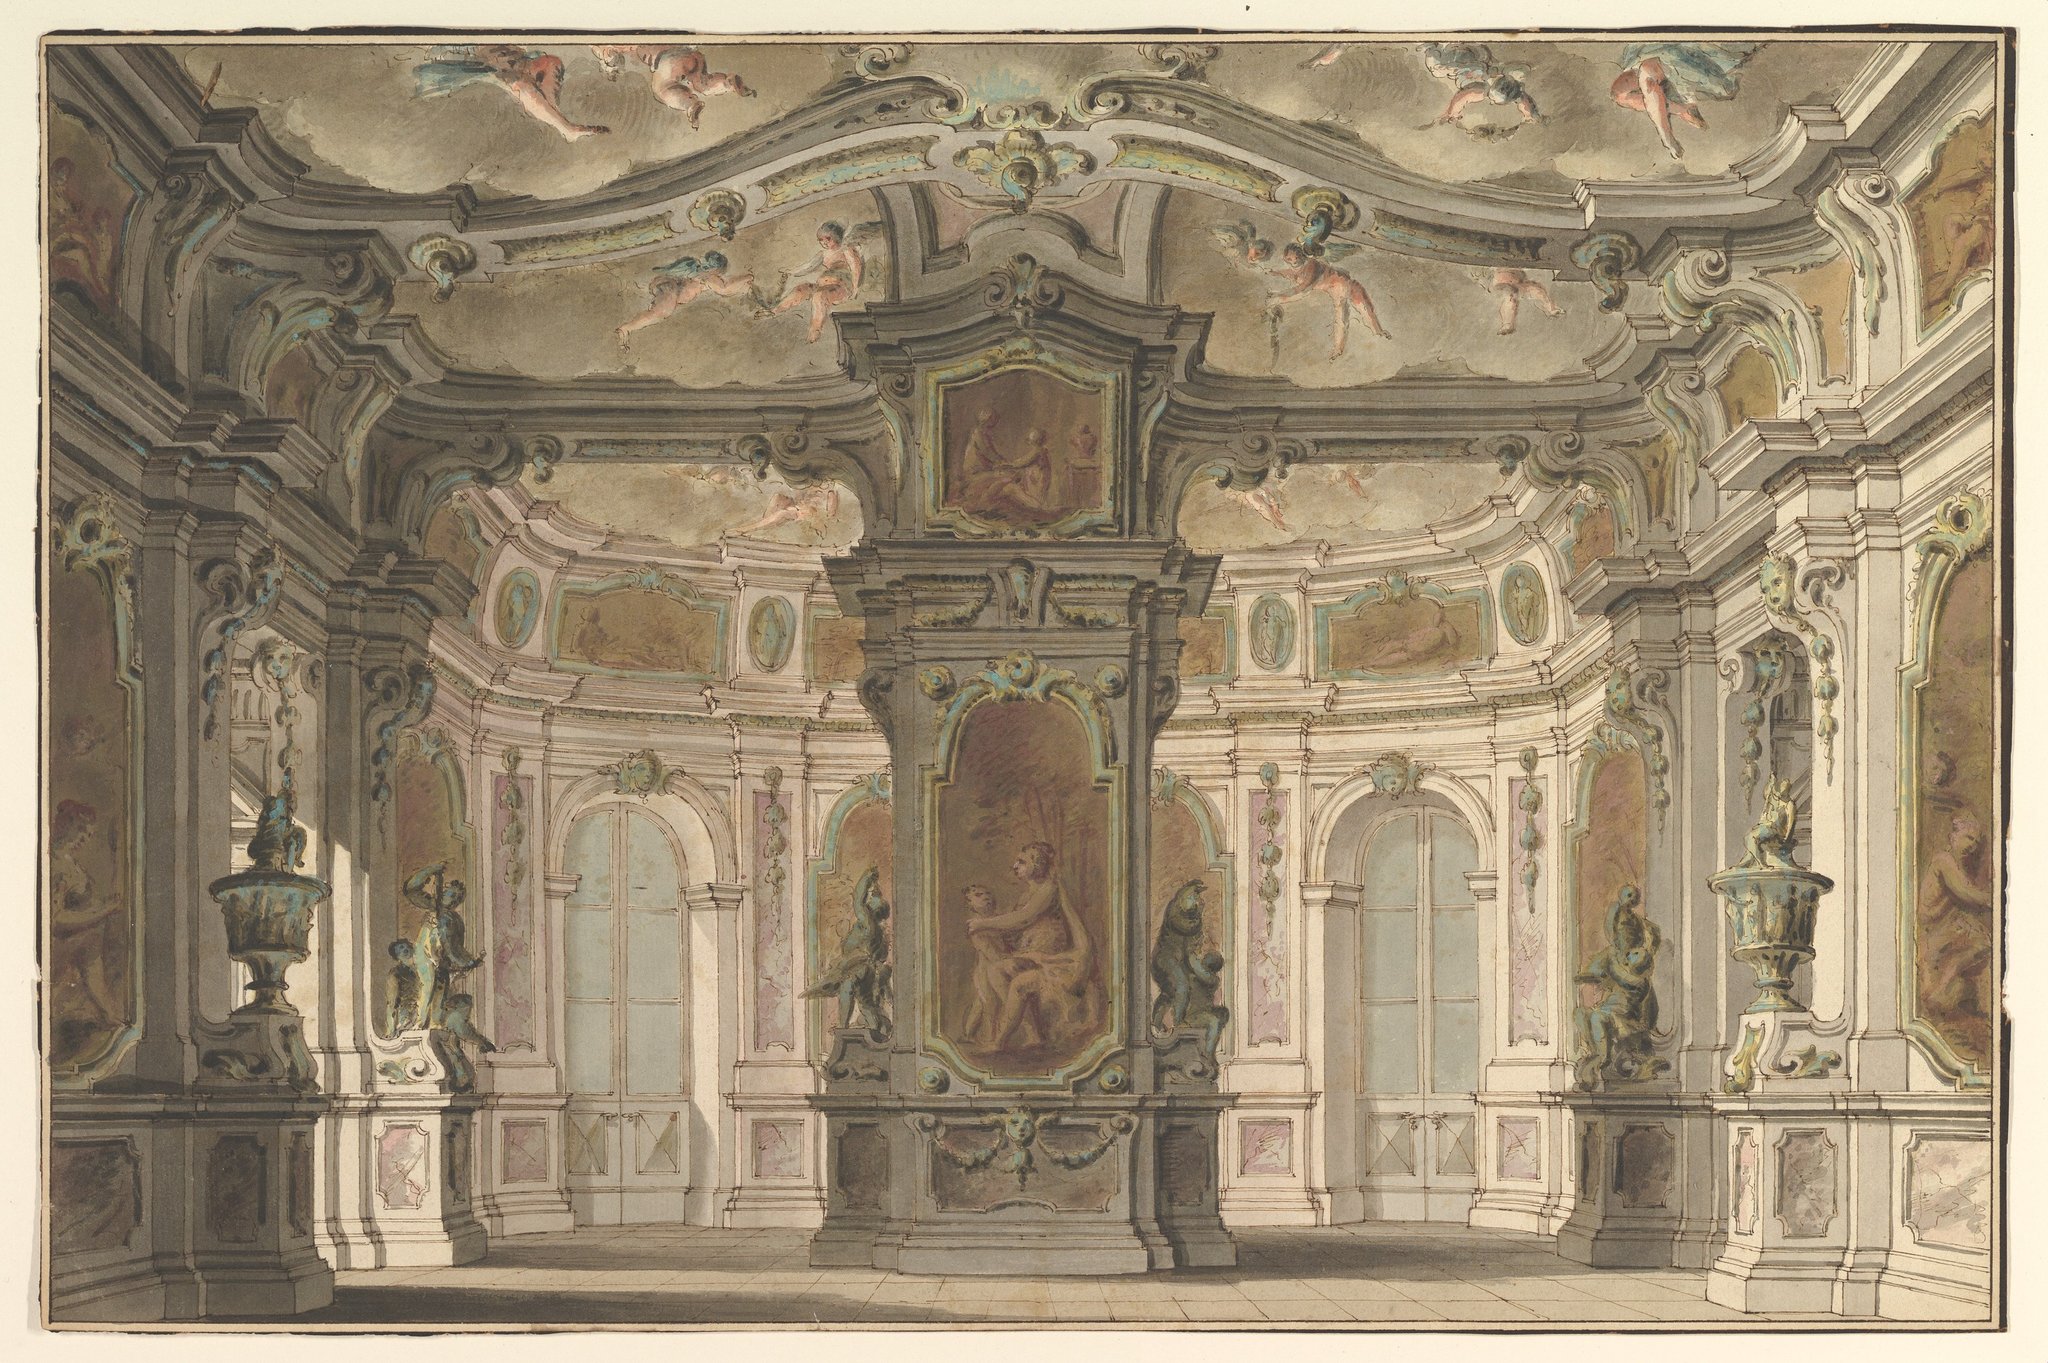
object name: drawing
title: Design for an Opera Set, a Congress of Cupids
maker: carlo zucchi the younger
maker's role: artist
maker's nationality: italian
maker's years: 1728-1796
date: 1701-1800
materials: watercolor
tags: opera,stage design